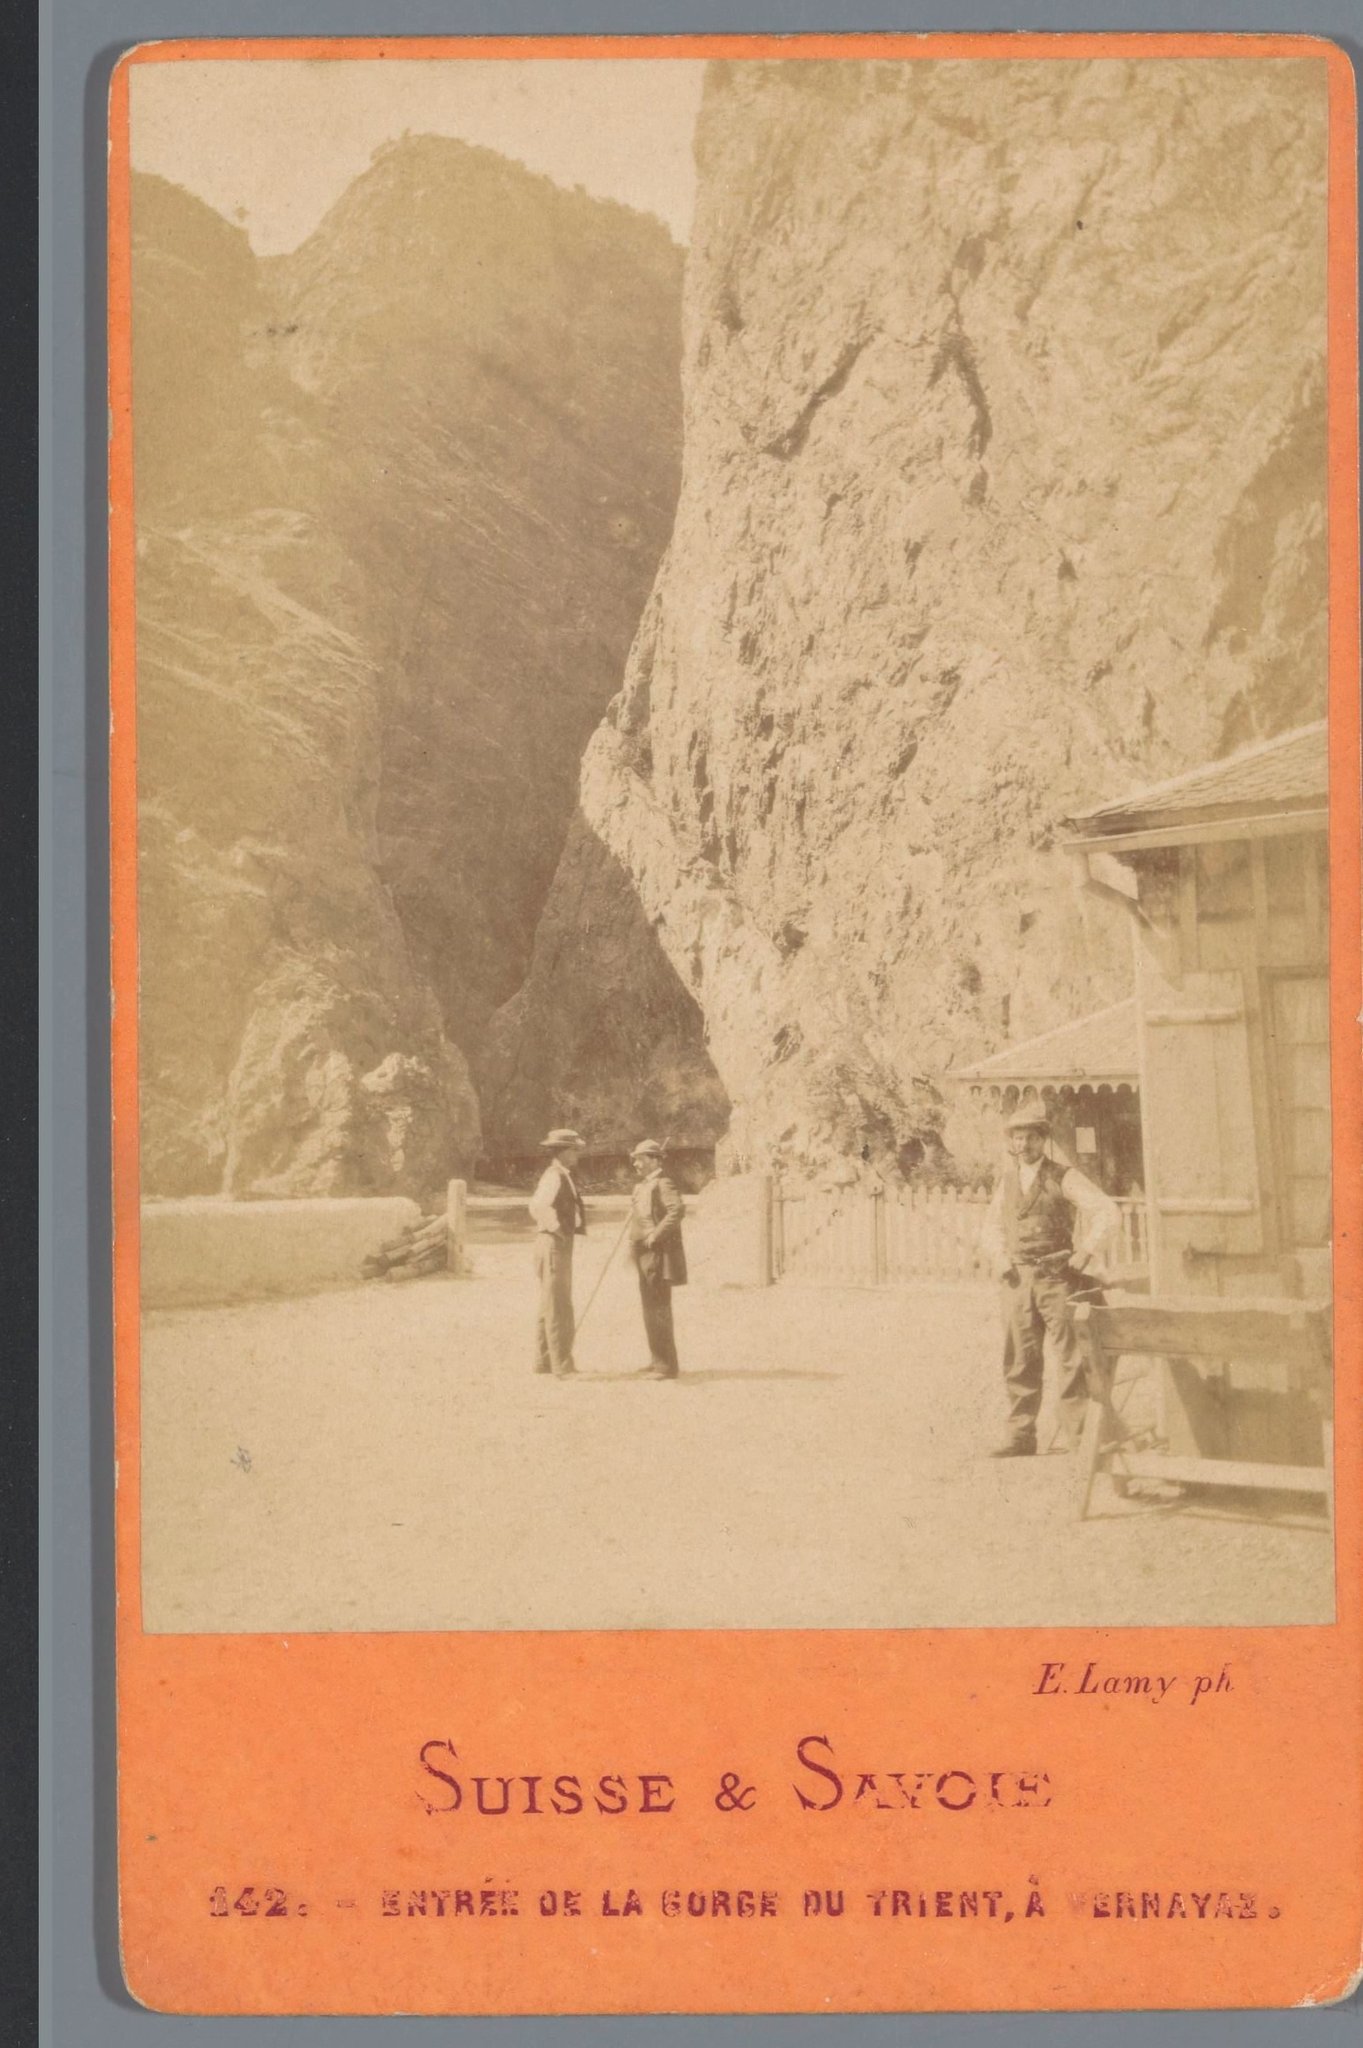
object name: carte de visite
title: Suisse & Savoie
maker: ernest eléonor pierre lamy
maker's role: publisher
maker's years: 1828-1900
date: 1868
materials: cardboard, paper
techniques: albumen print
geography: martigny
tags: ravine, chasm, abyss, canyon, bridge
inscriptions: number: ‘142.’